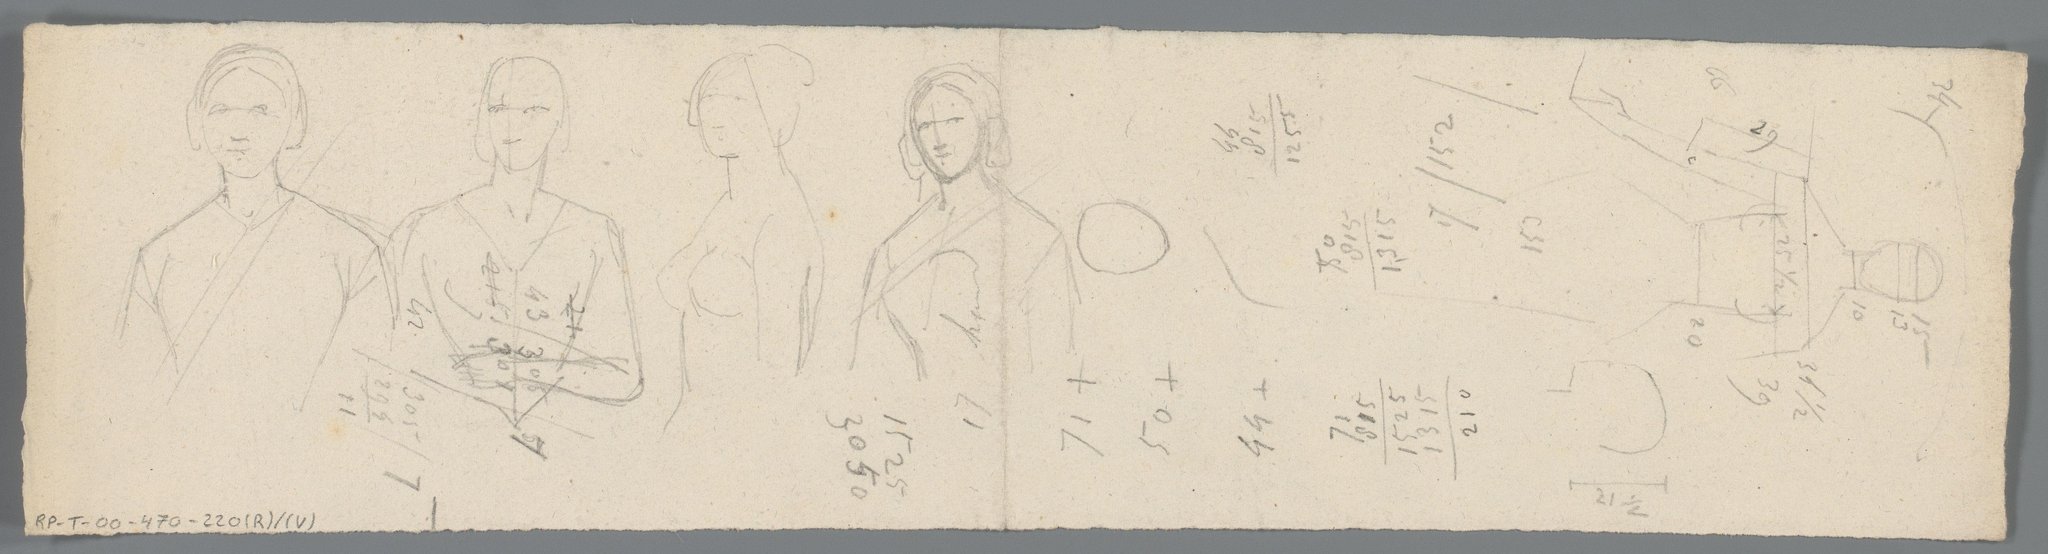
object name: drawing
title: Studies van vrouwen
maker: jacobus everhardus josephus van den berg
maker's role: draughtsman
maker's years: 1802-1861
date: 1812-1861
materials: paper, pencil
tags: the (nude) human figure; 'corpo humano' (ripa) - aa - female human figure